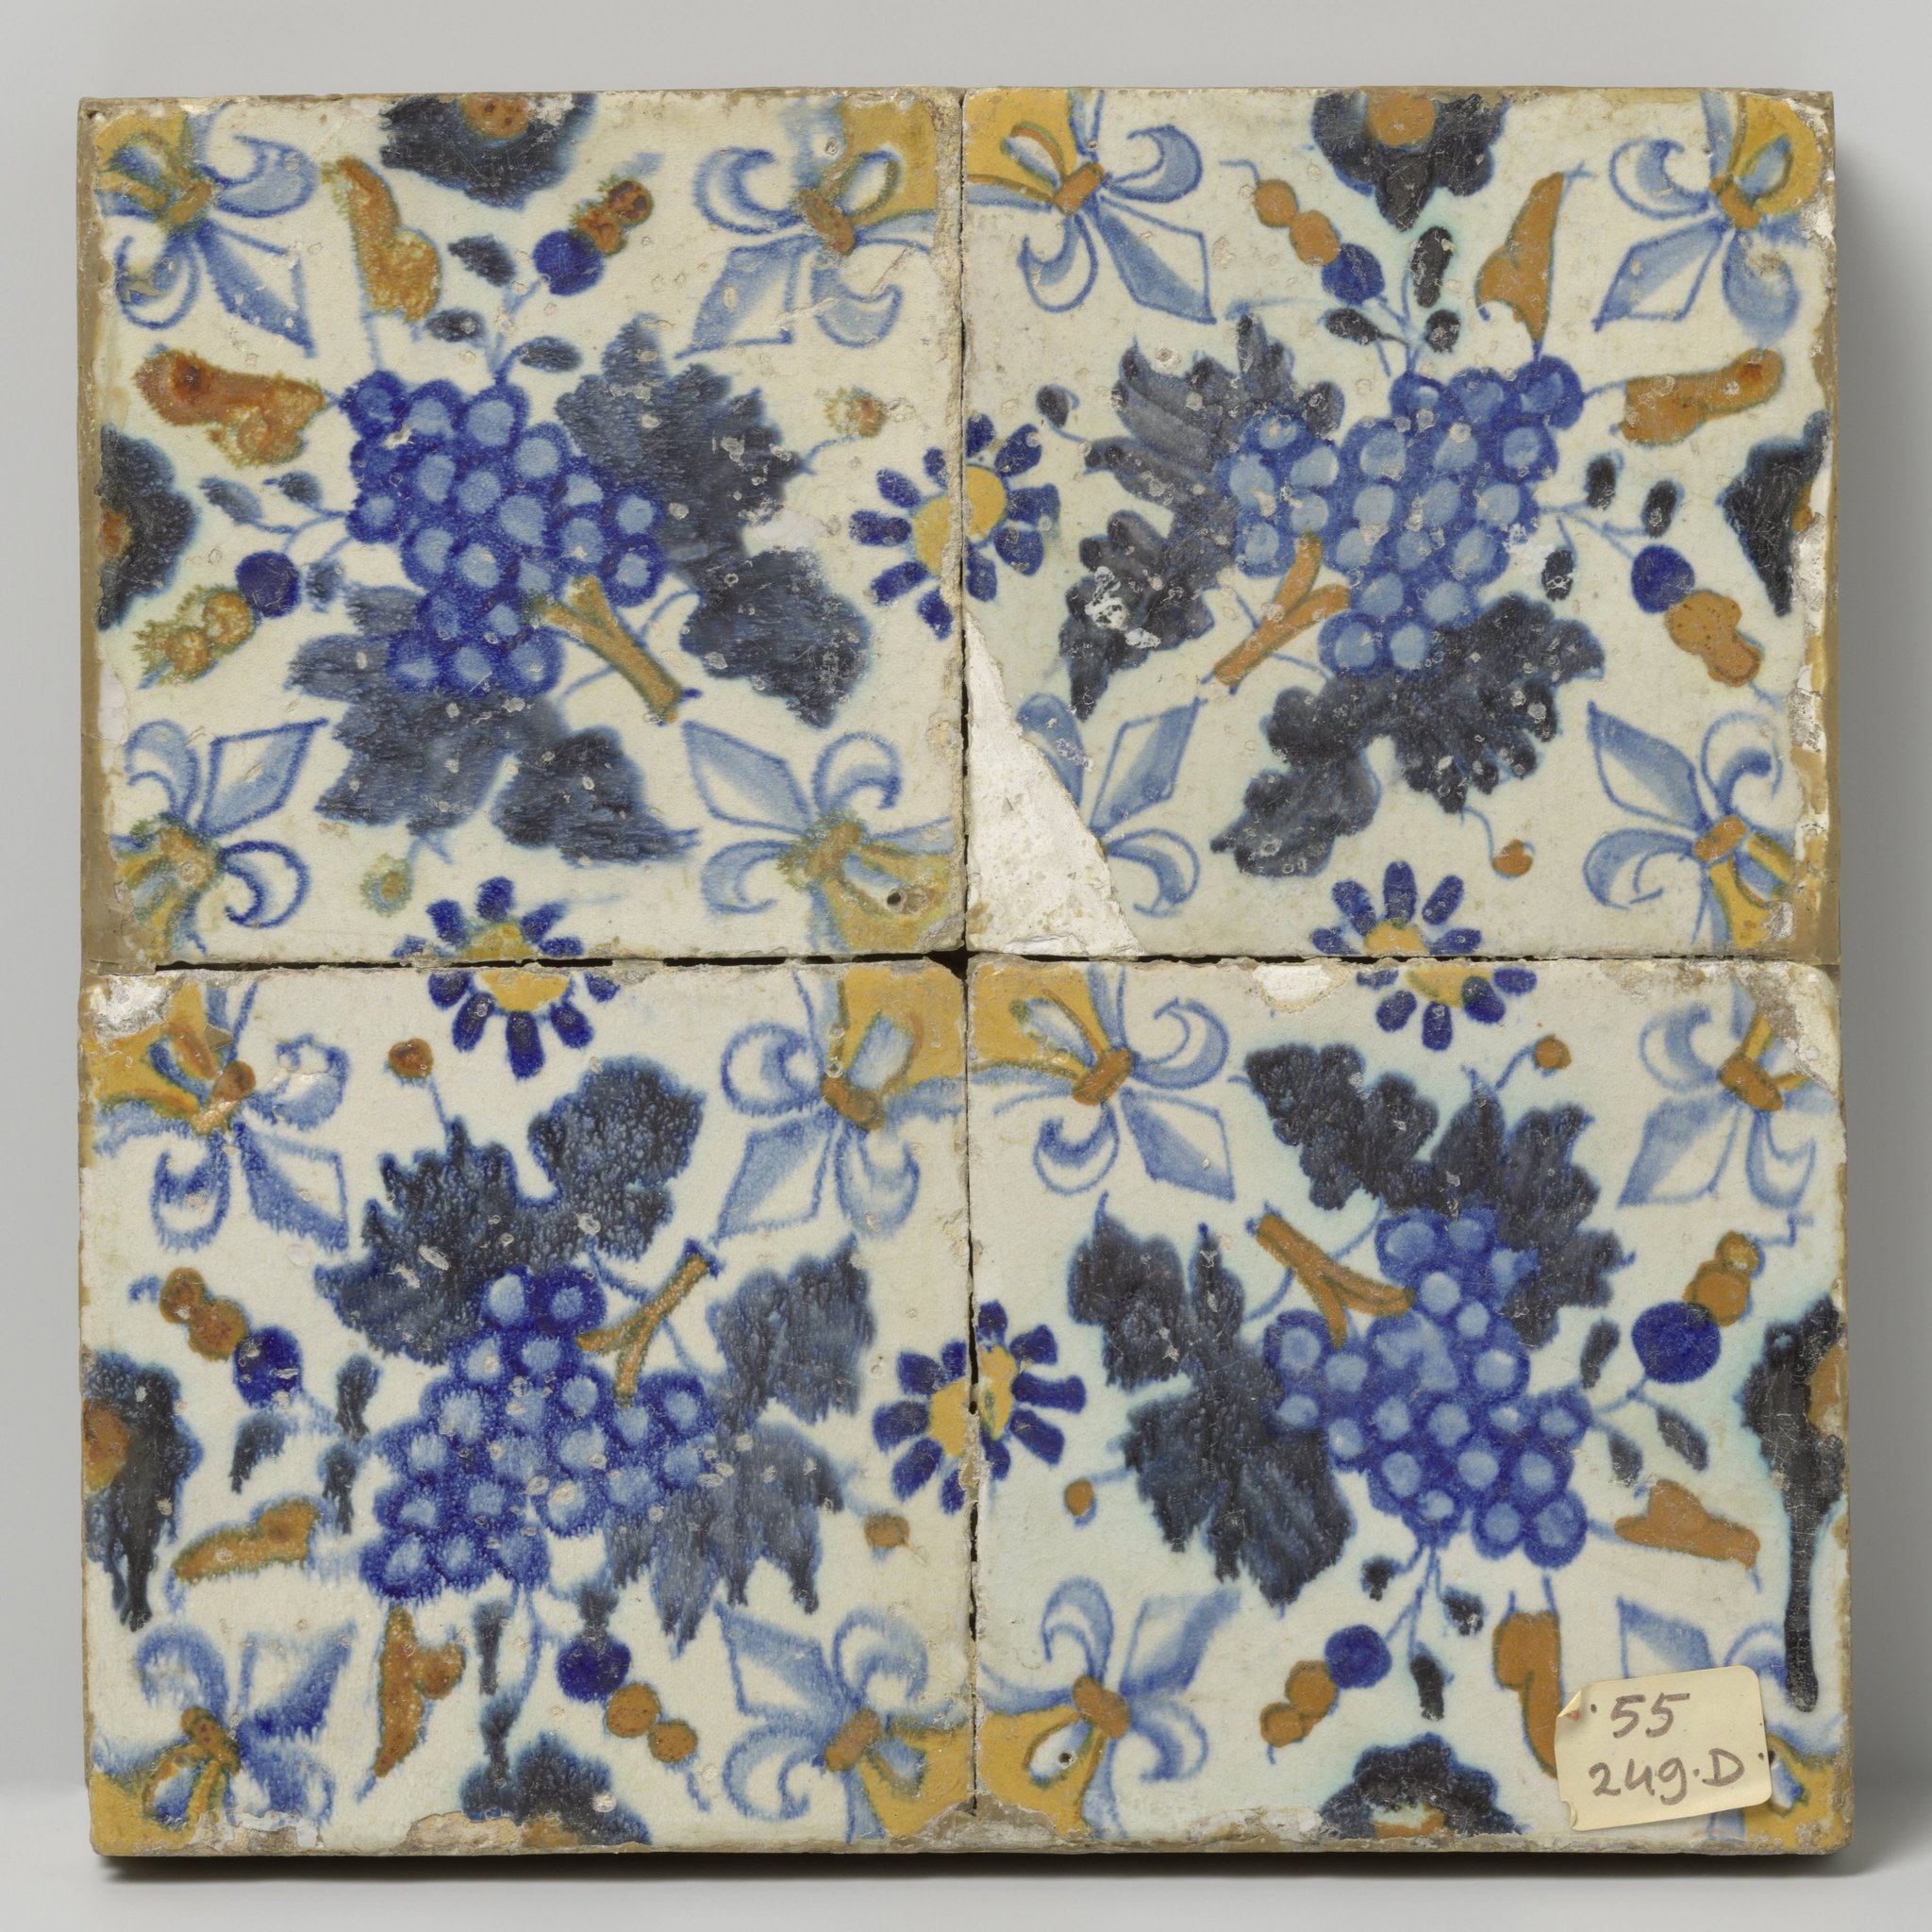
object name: tegelveld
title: Veld van vier tegels met druiventrossen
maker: Anonymous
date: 1600-1625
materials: earthenware, glaze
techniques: maiolica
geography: netherlands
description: Veld van vier tegels (2 x 2) elk met een veelkleurig (blauw, groen, oranje en geel) geschilderde druiventros, diagonaal geplaatst. Langs de randen, een halve rozet en in de hoeken, een lelie.